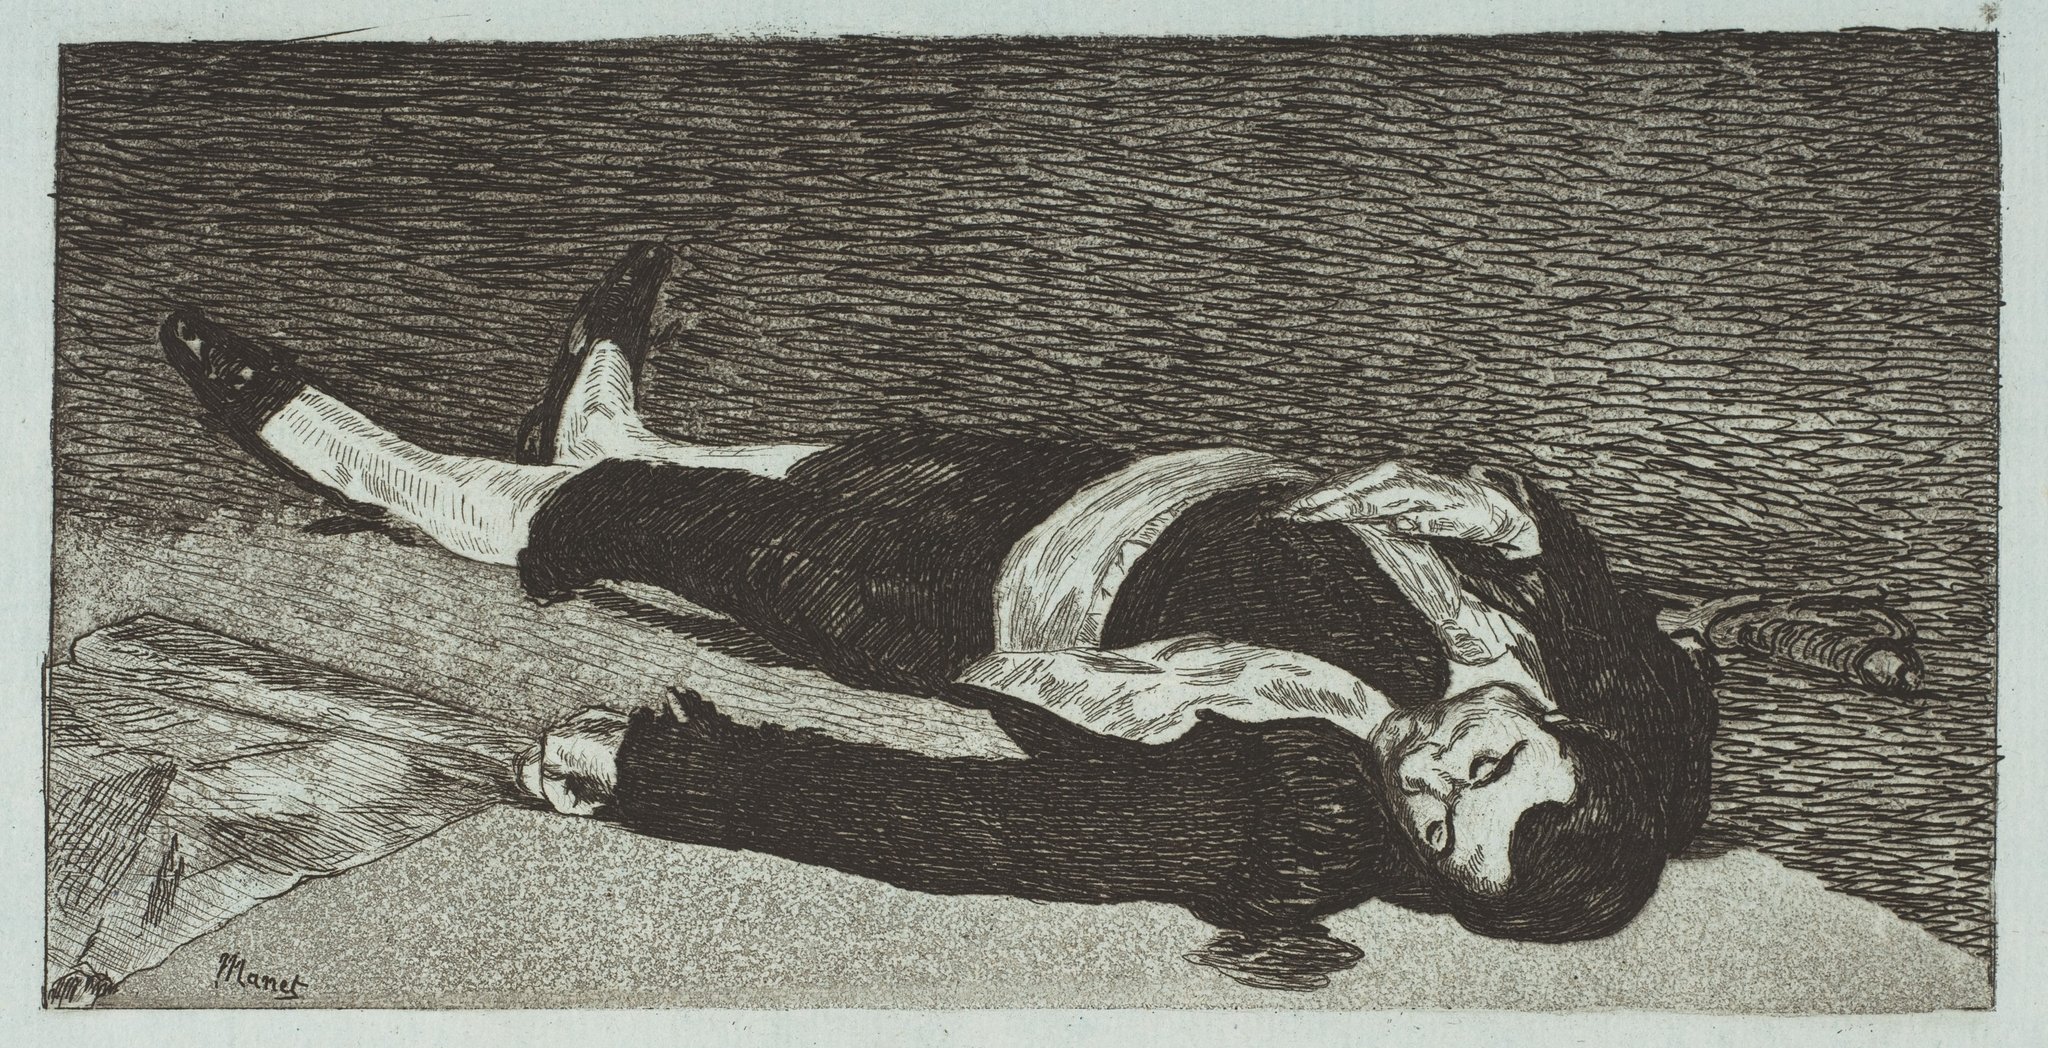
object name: print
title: Dead Toreador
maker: édouard manet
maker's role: artist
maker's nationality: french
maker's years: 1832-1883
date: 1867-1868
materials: paper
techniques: aquatint, etching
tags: men,death